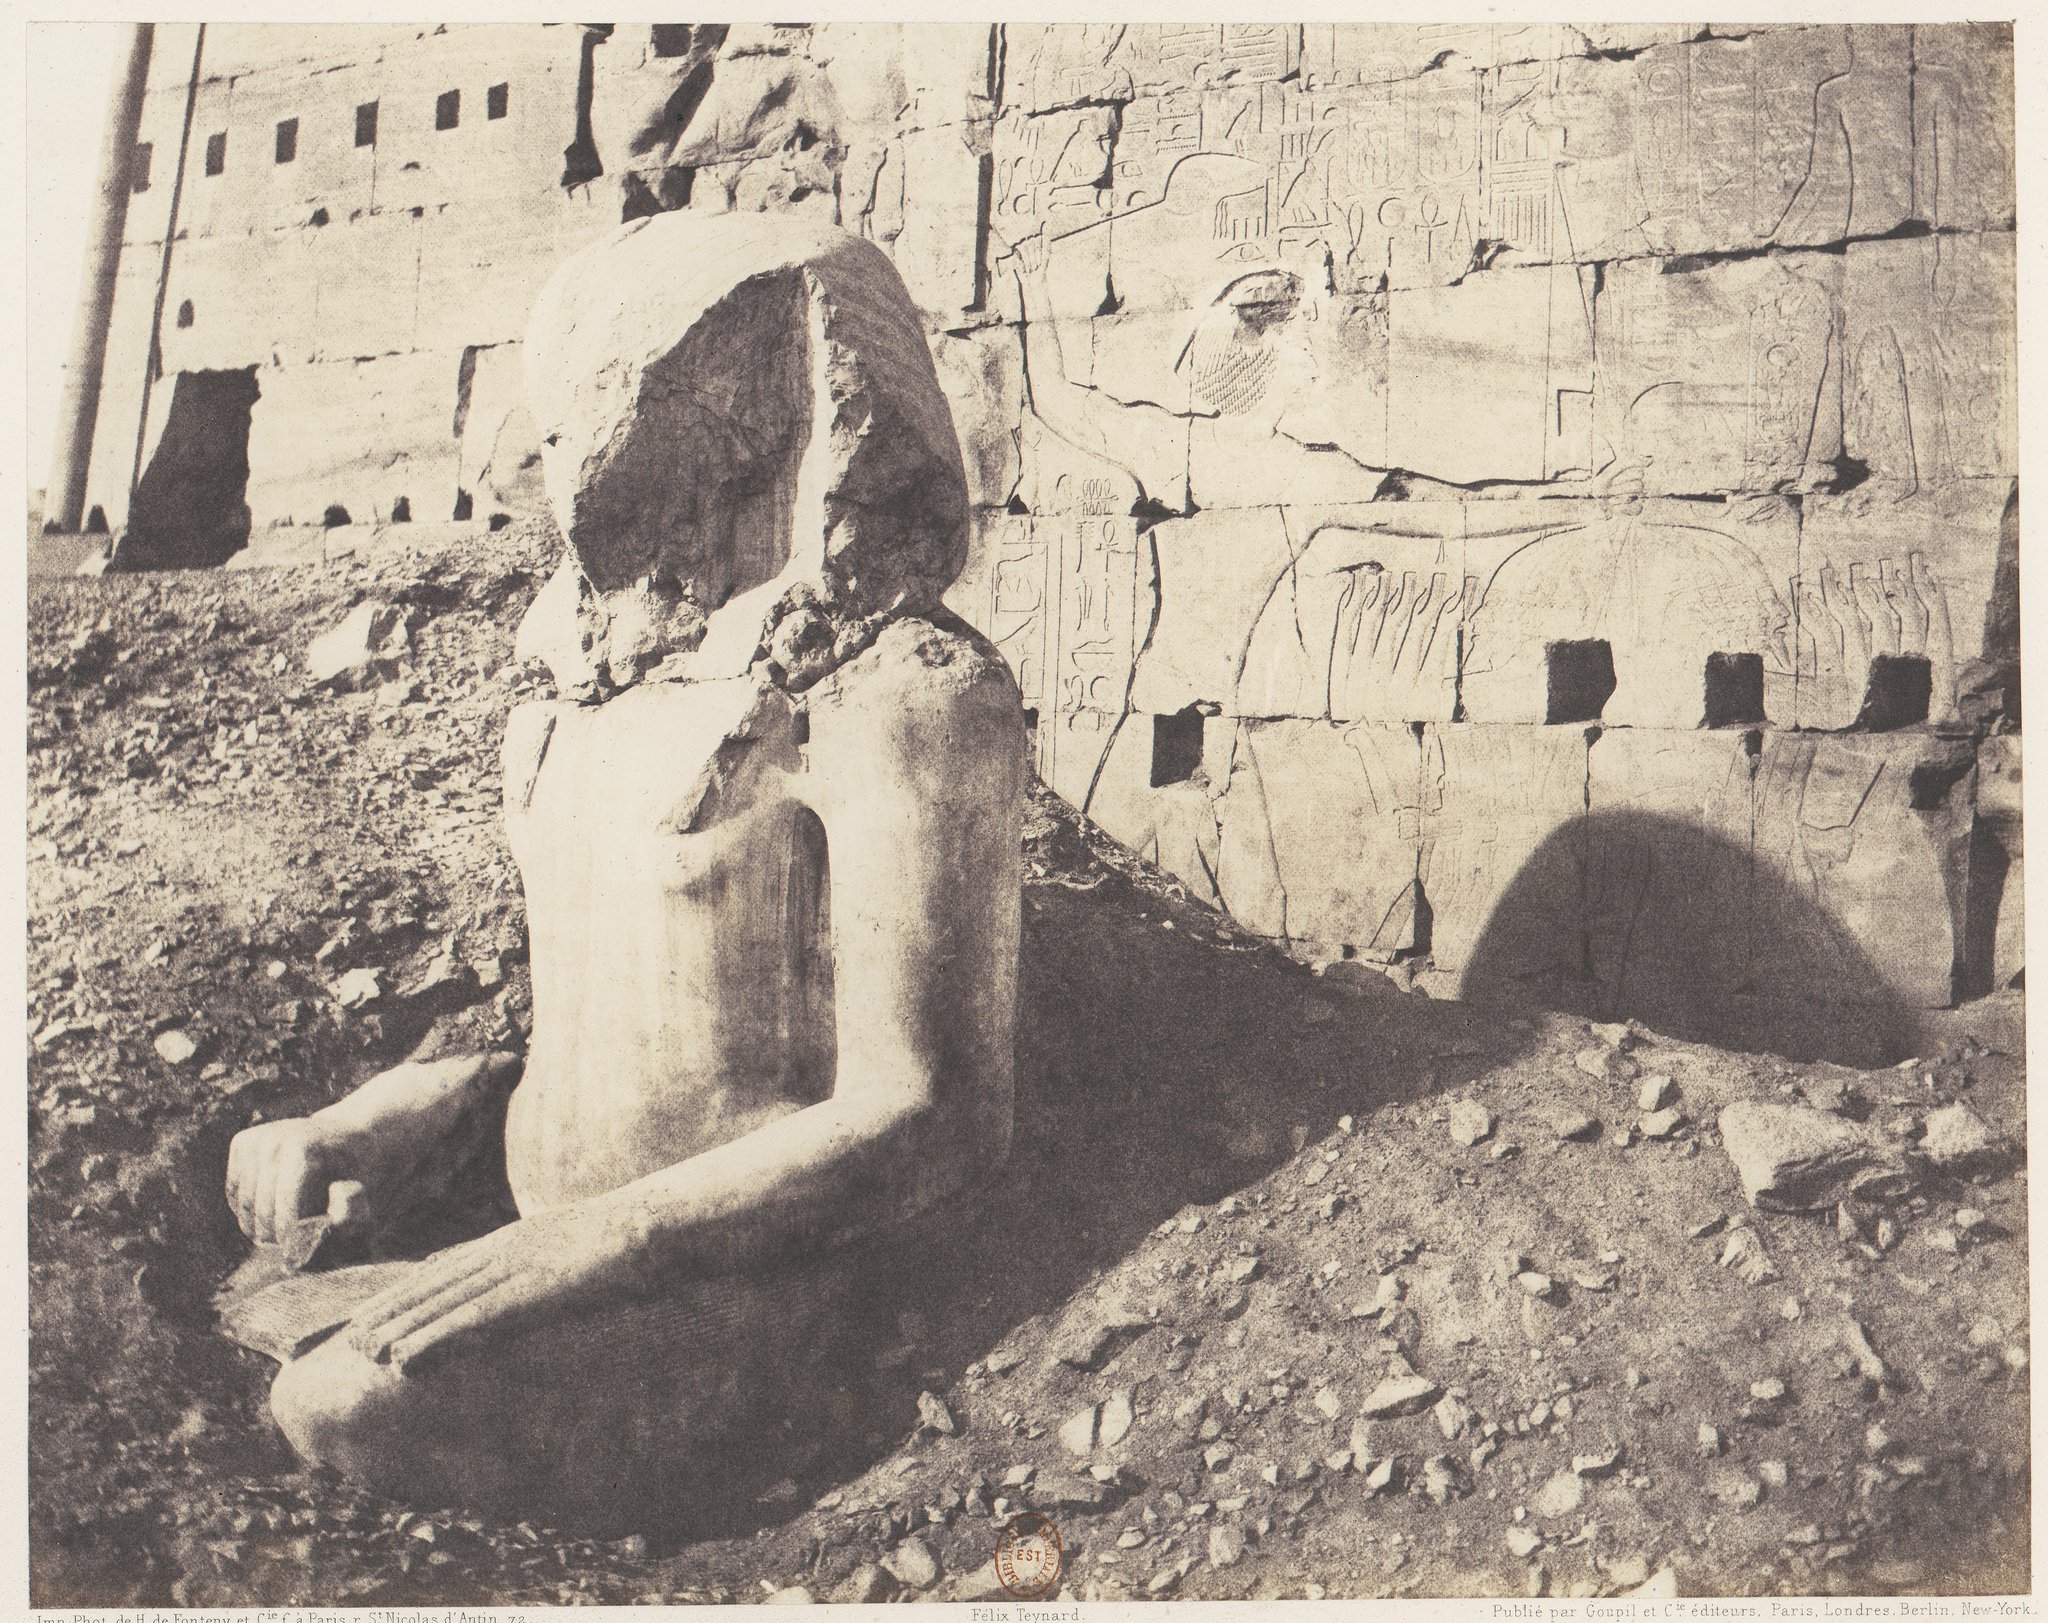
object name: photograph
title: Karnak (Thèbes), Troisième Pylône - Colosse de Spath Calcaire, en D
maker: félix teynard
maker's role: artist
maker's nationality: french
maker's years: 1817-1892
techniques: paper negative, salted paper print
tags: sculpture,ruins